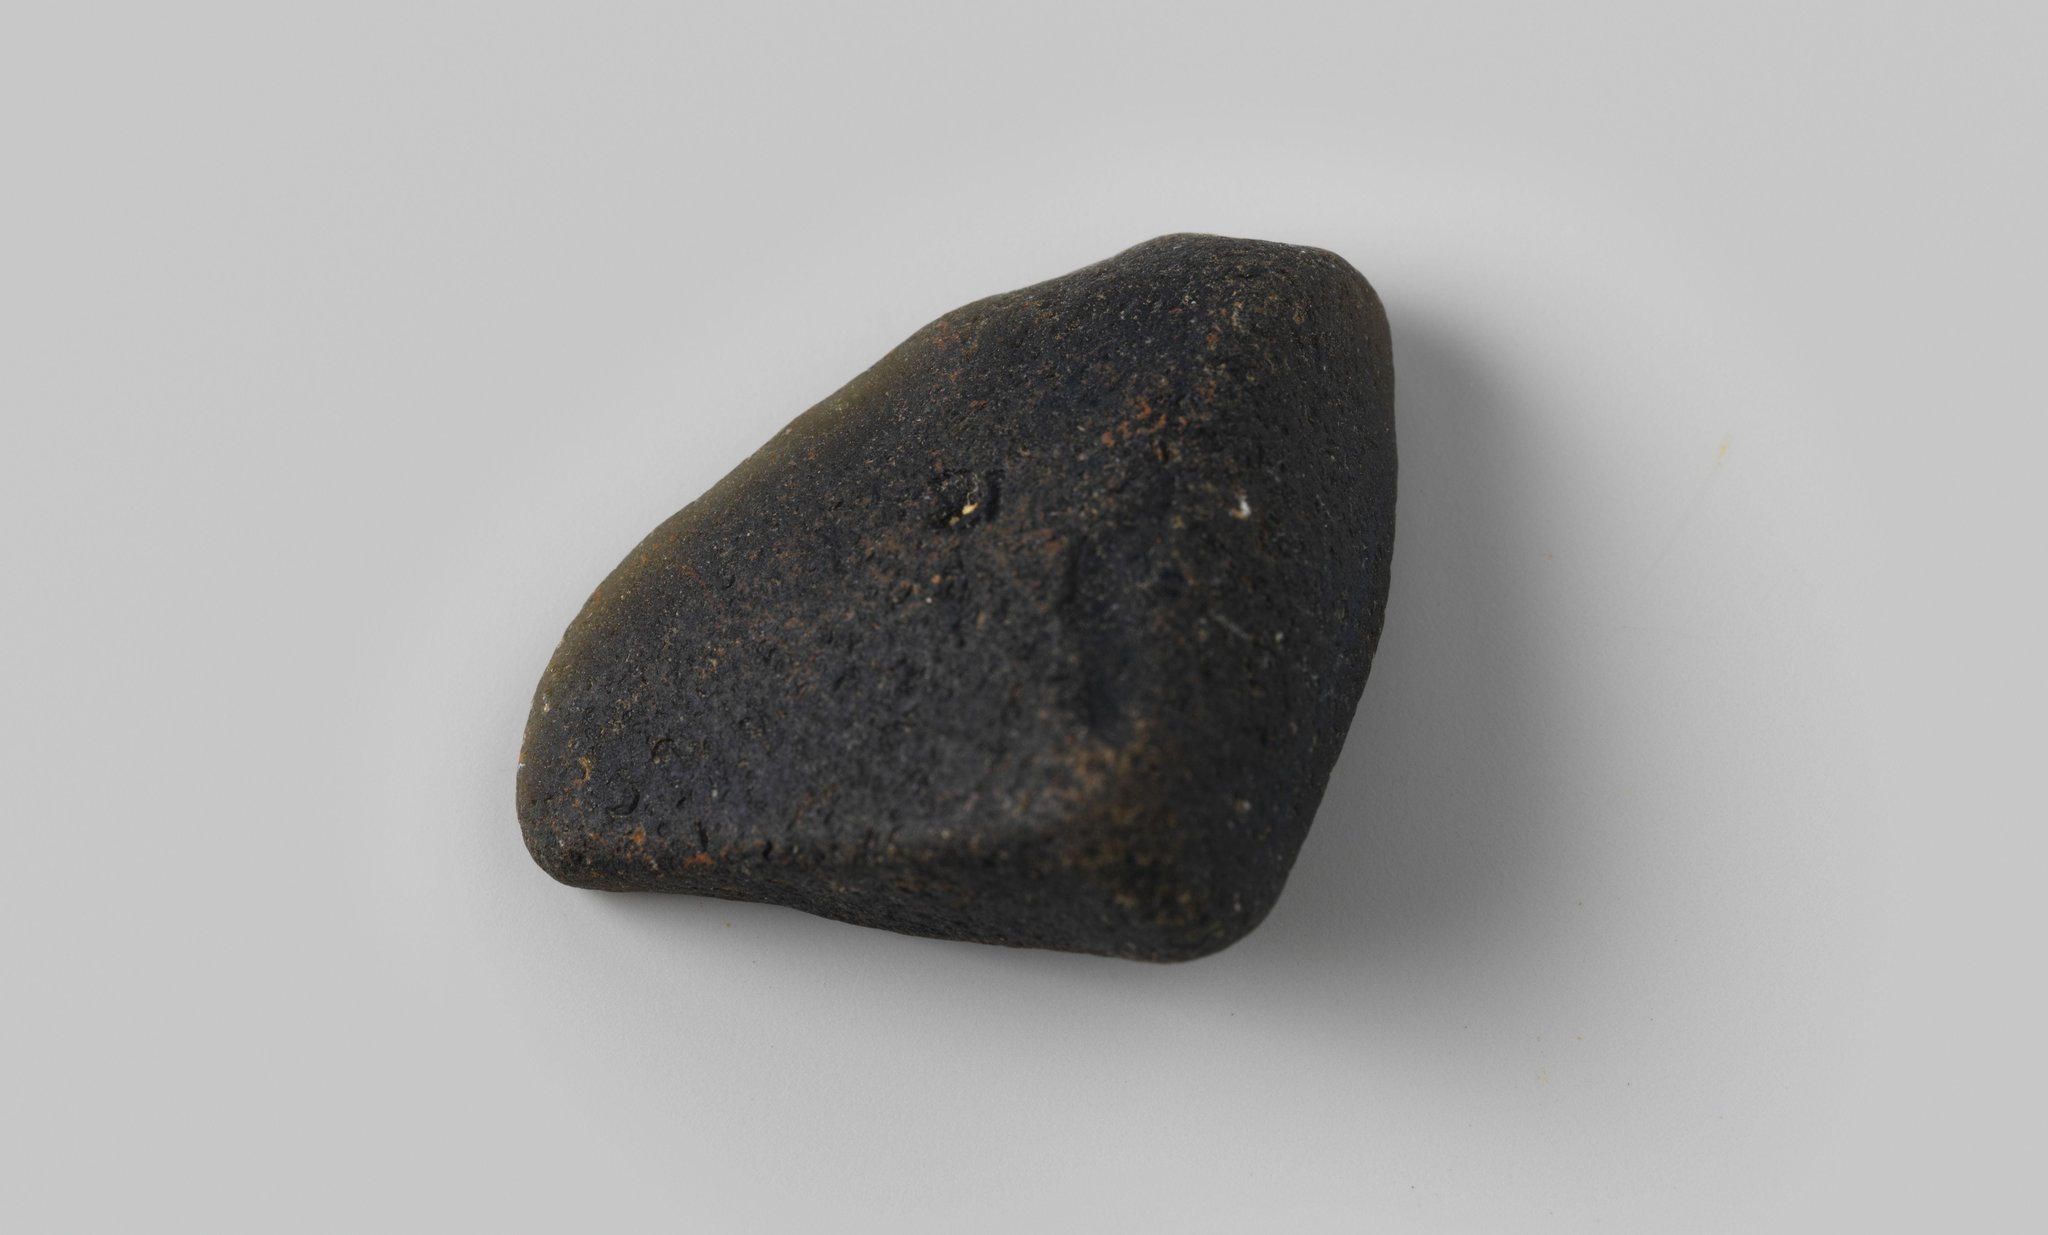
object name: wine bottle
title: Scherf van een wijnfles uit het wrak van de Oost-Indiëvaarder Hollandia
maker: Anonymous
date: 1700-1743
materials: glass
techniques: green glass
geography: netherlands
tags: verenigde oostindische compagnie, hollandia (schip), annet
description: Typologically not identifiable, base, fragm.